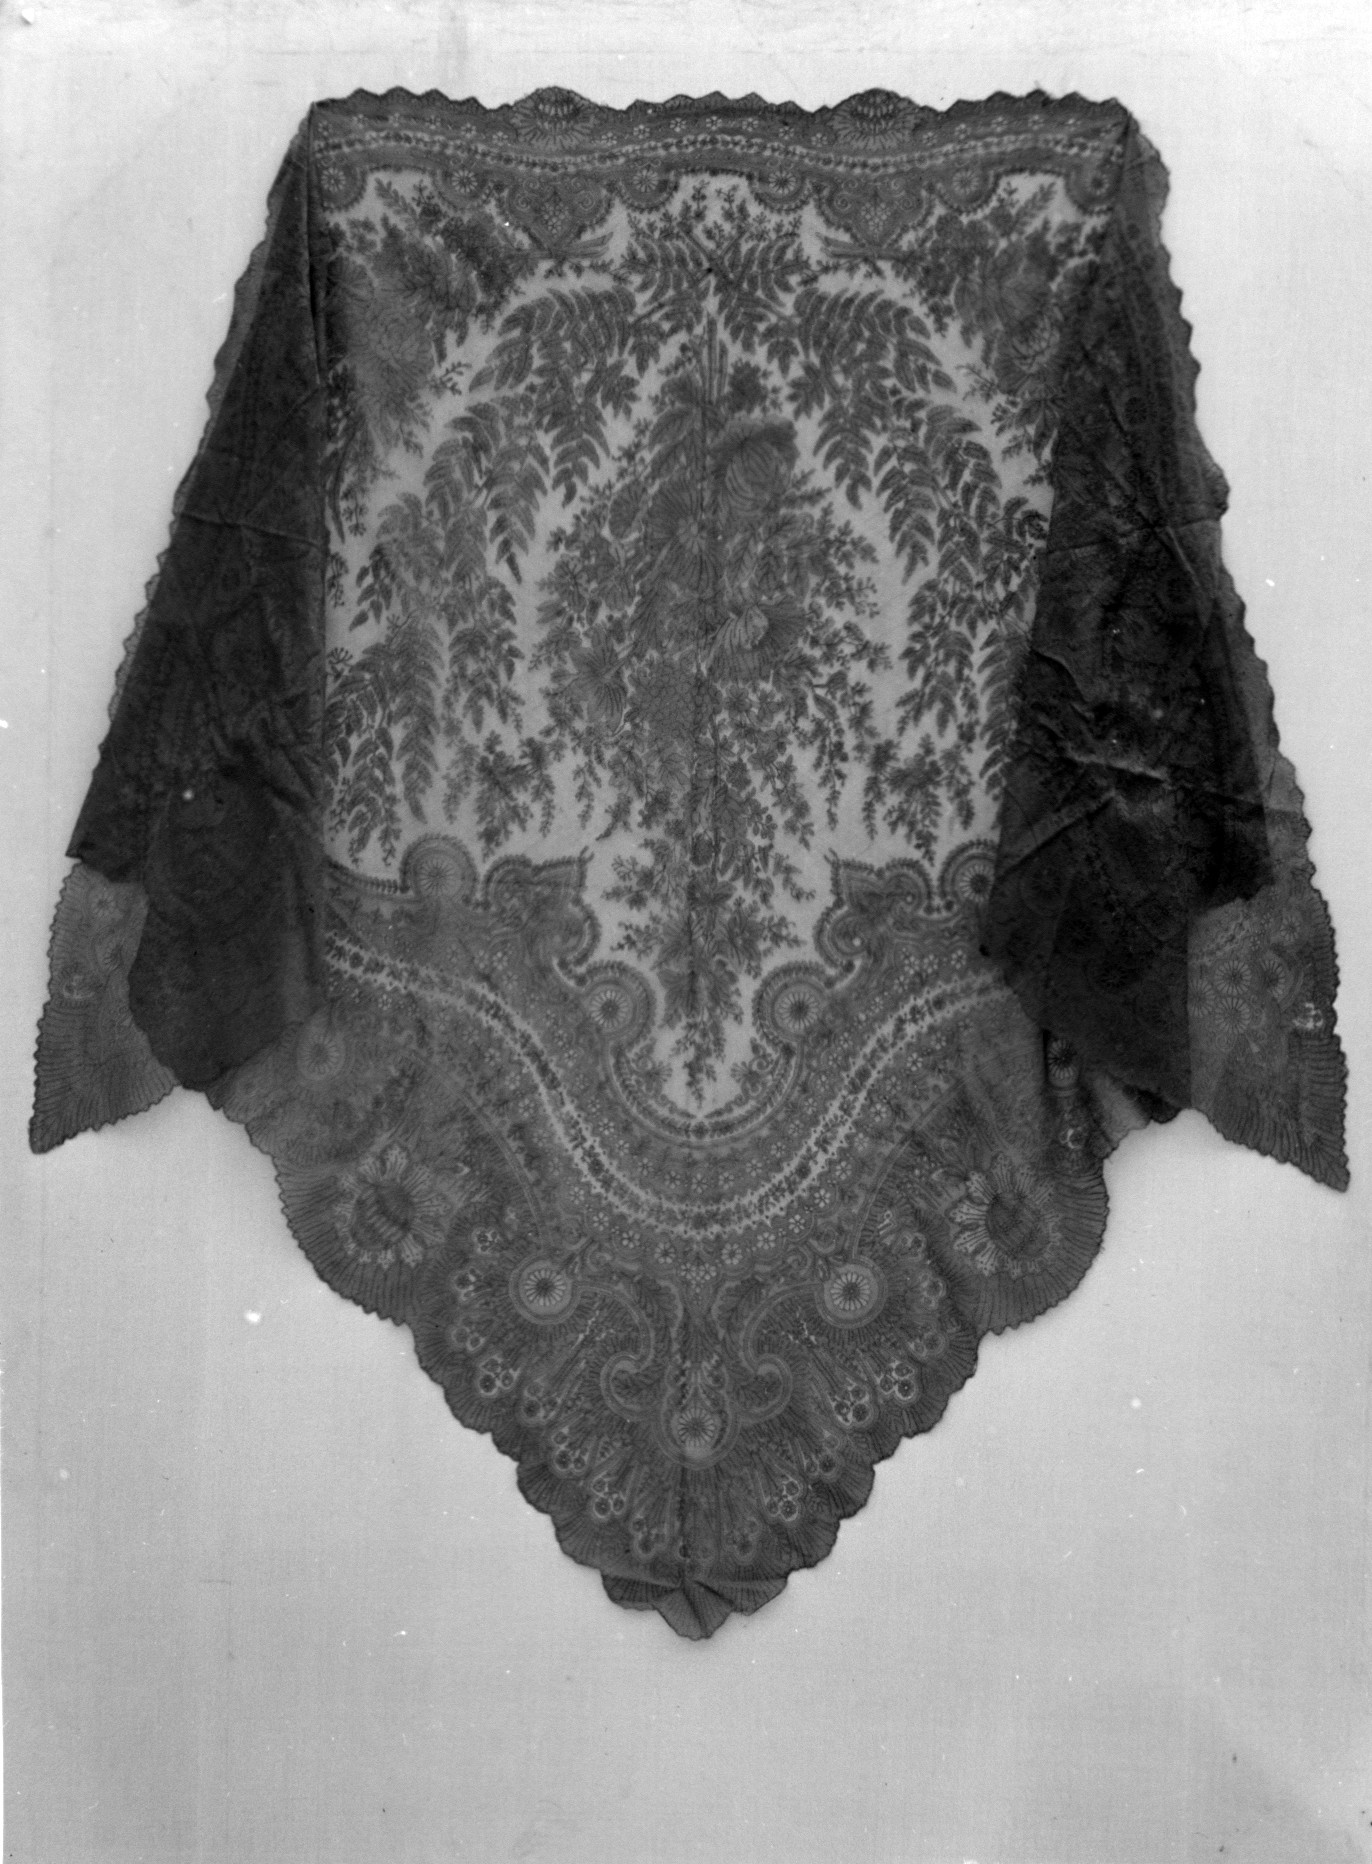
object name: shawl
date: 1801-1900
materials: lace, wool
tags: flowers